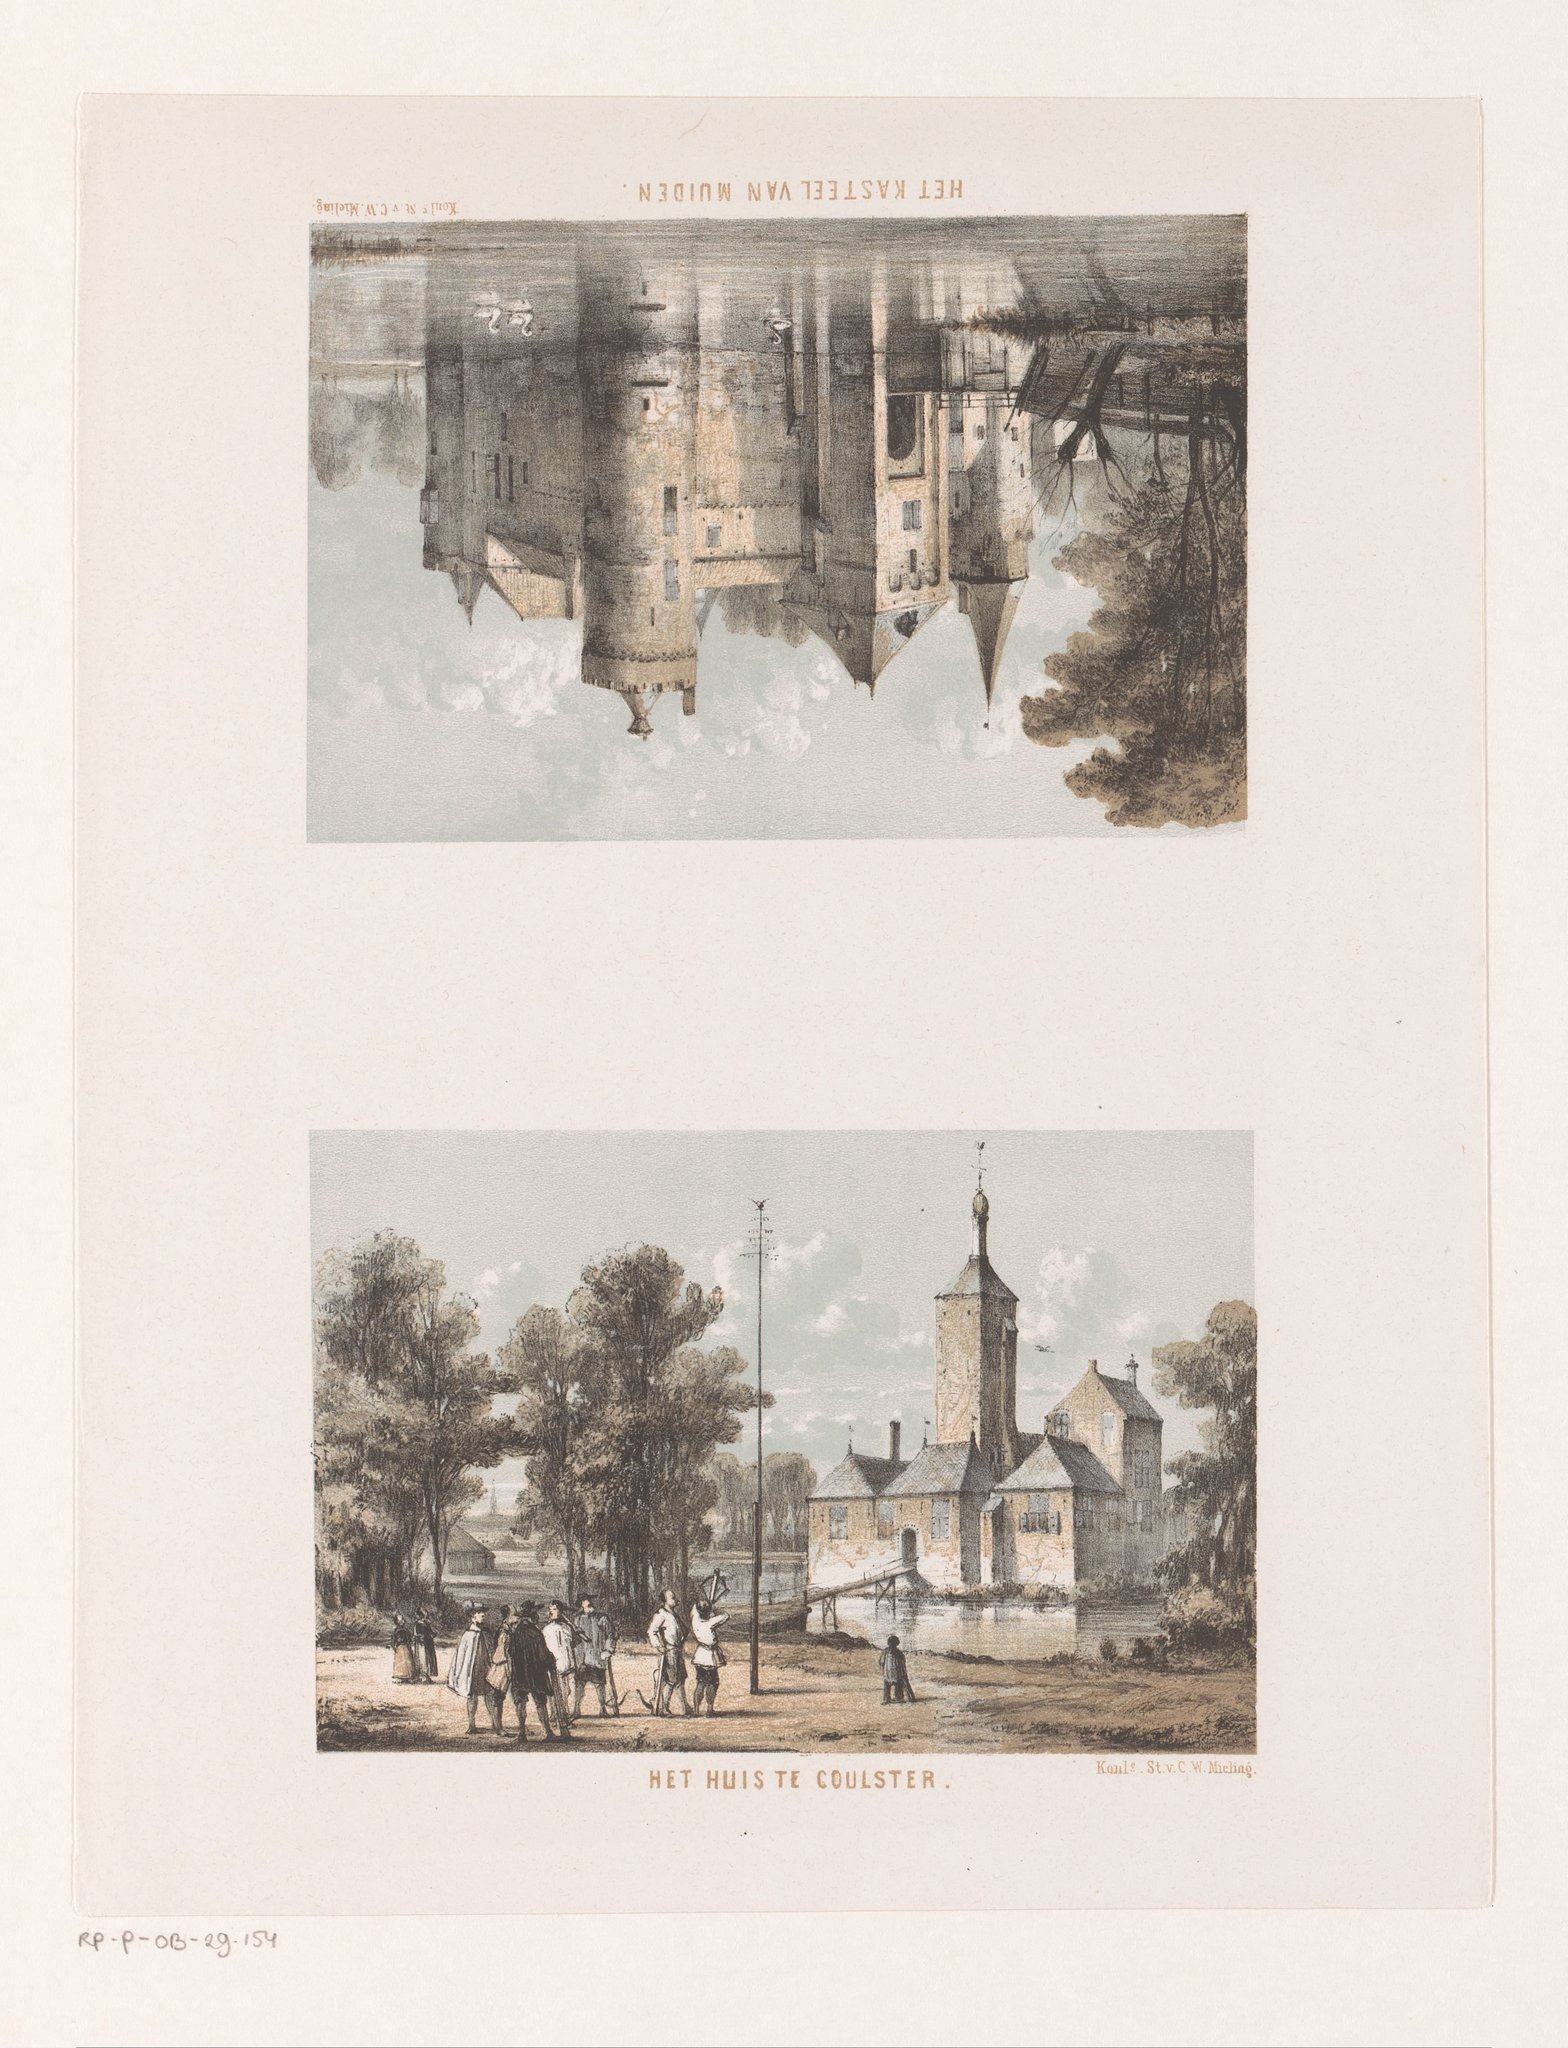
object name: print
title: Twee voorstellingen van kasteel Ter Coulster en het kasteel van Muiden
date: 1854-1861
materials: paper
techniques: tone lithography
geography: the hague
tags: castle, shooting-the-bird (on a high pole)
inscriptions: collector's mark: Lugt 2228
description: Op de onderste voorstelling staat een groepje mannen. Een van hen heeft zijn handboog gericht op een staande wip. De mannen zijn gekleed in middeleeuwse kleding.